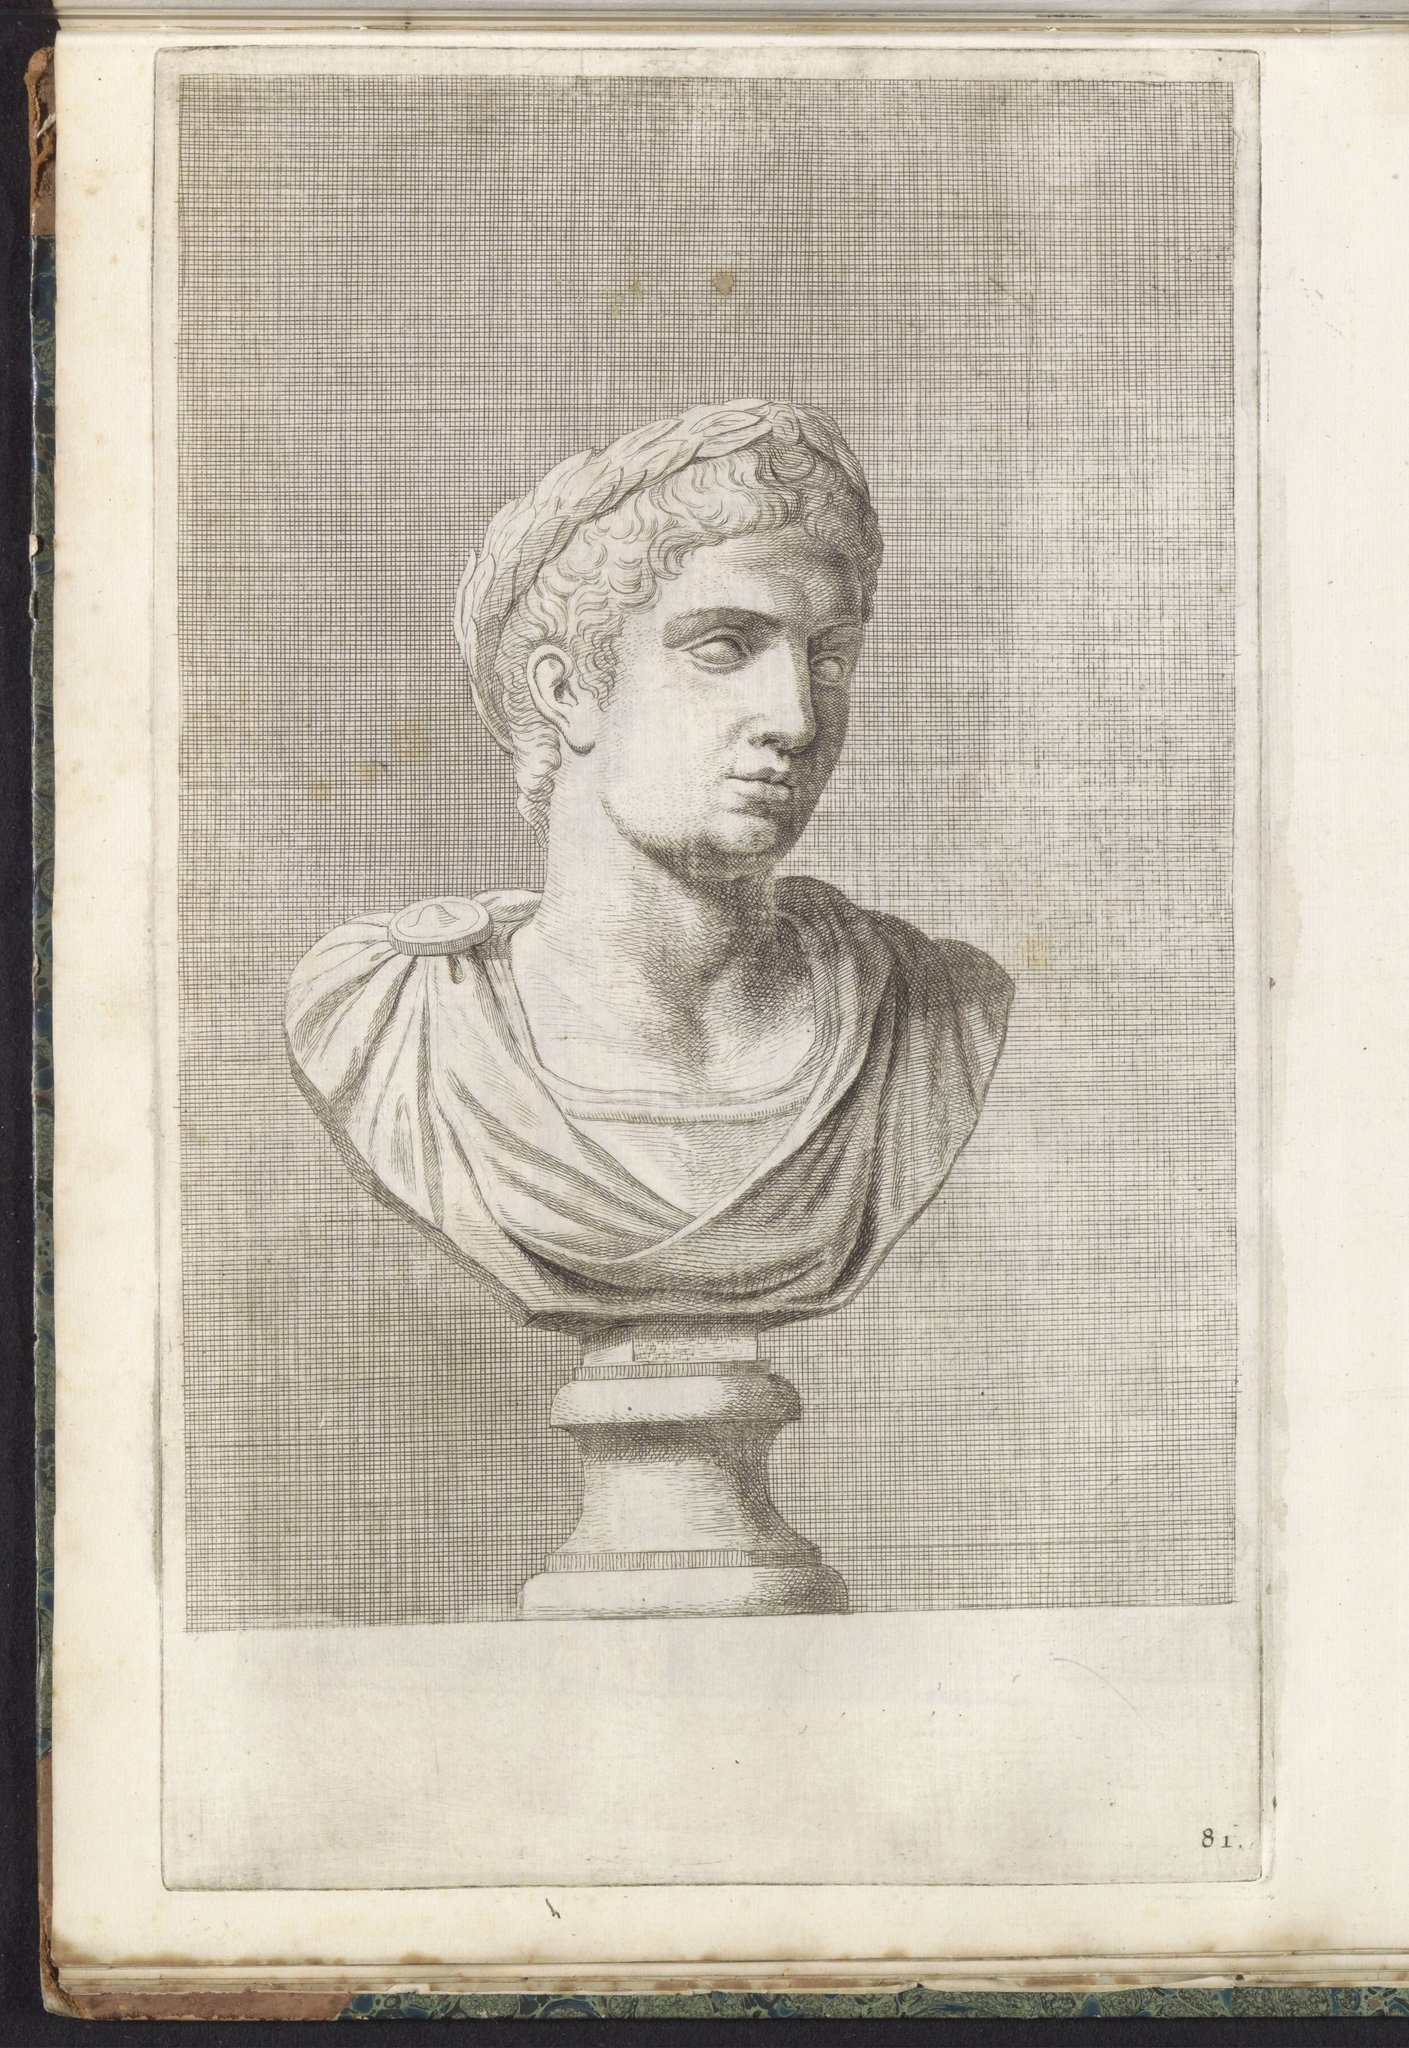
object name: album leaf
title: Buste van een jonge man met lauwerkrans, naar rechts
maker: hubert quellinus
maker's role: print maker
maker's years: 1619-1687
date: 1646-1670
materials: paper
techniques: engraving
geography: antwerp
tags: piece of sculpture, reproduction of a piece of sculpture, male persons from classical history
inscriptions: number: ‘81’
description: De prent maakt deel uit van een album met een serie prenten naar de sculpturen in de verzameling van Gerard Reynst.